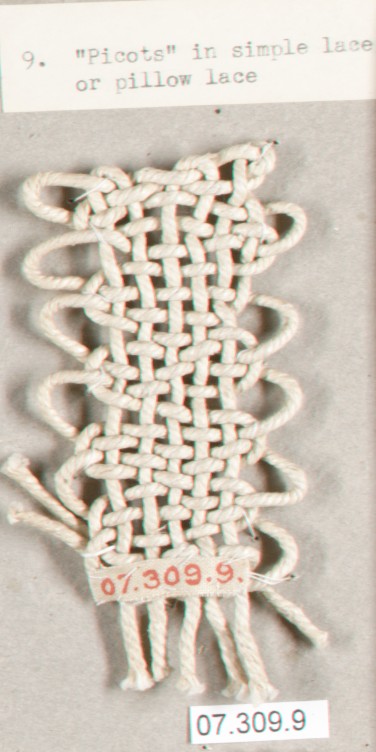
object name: stitch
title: Example of lace stitch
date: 1801-2000